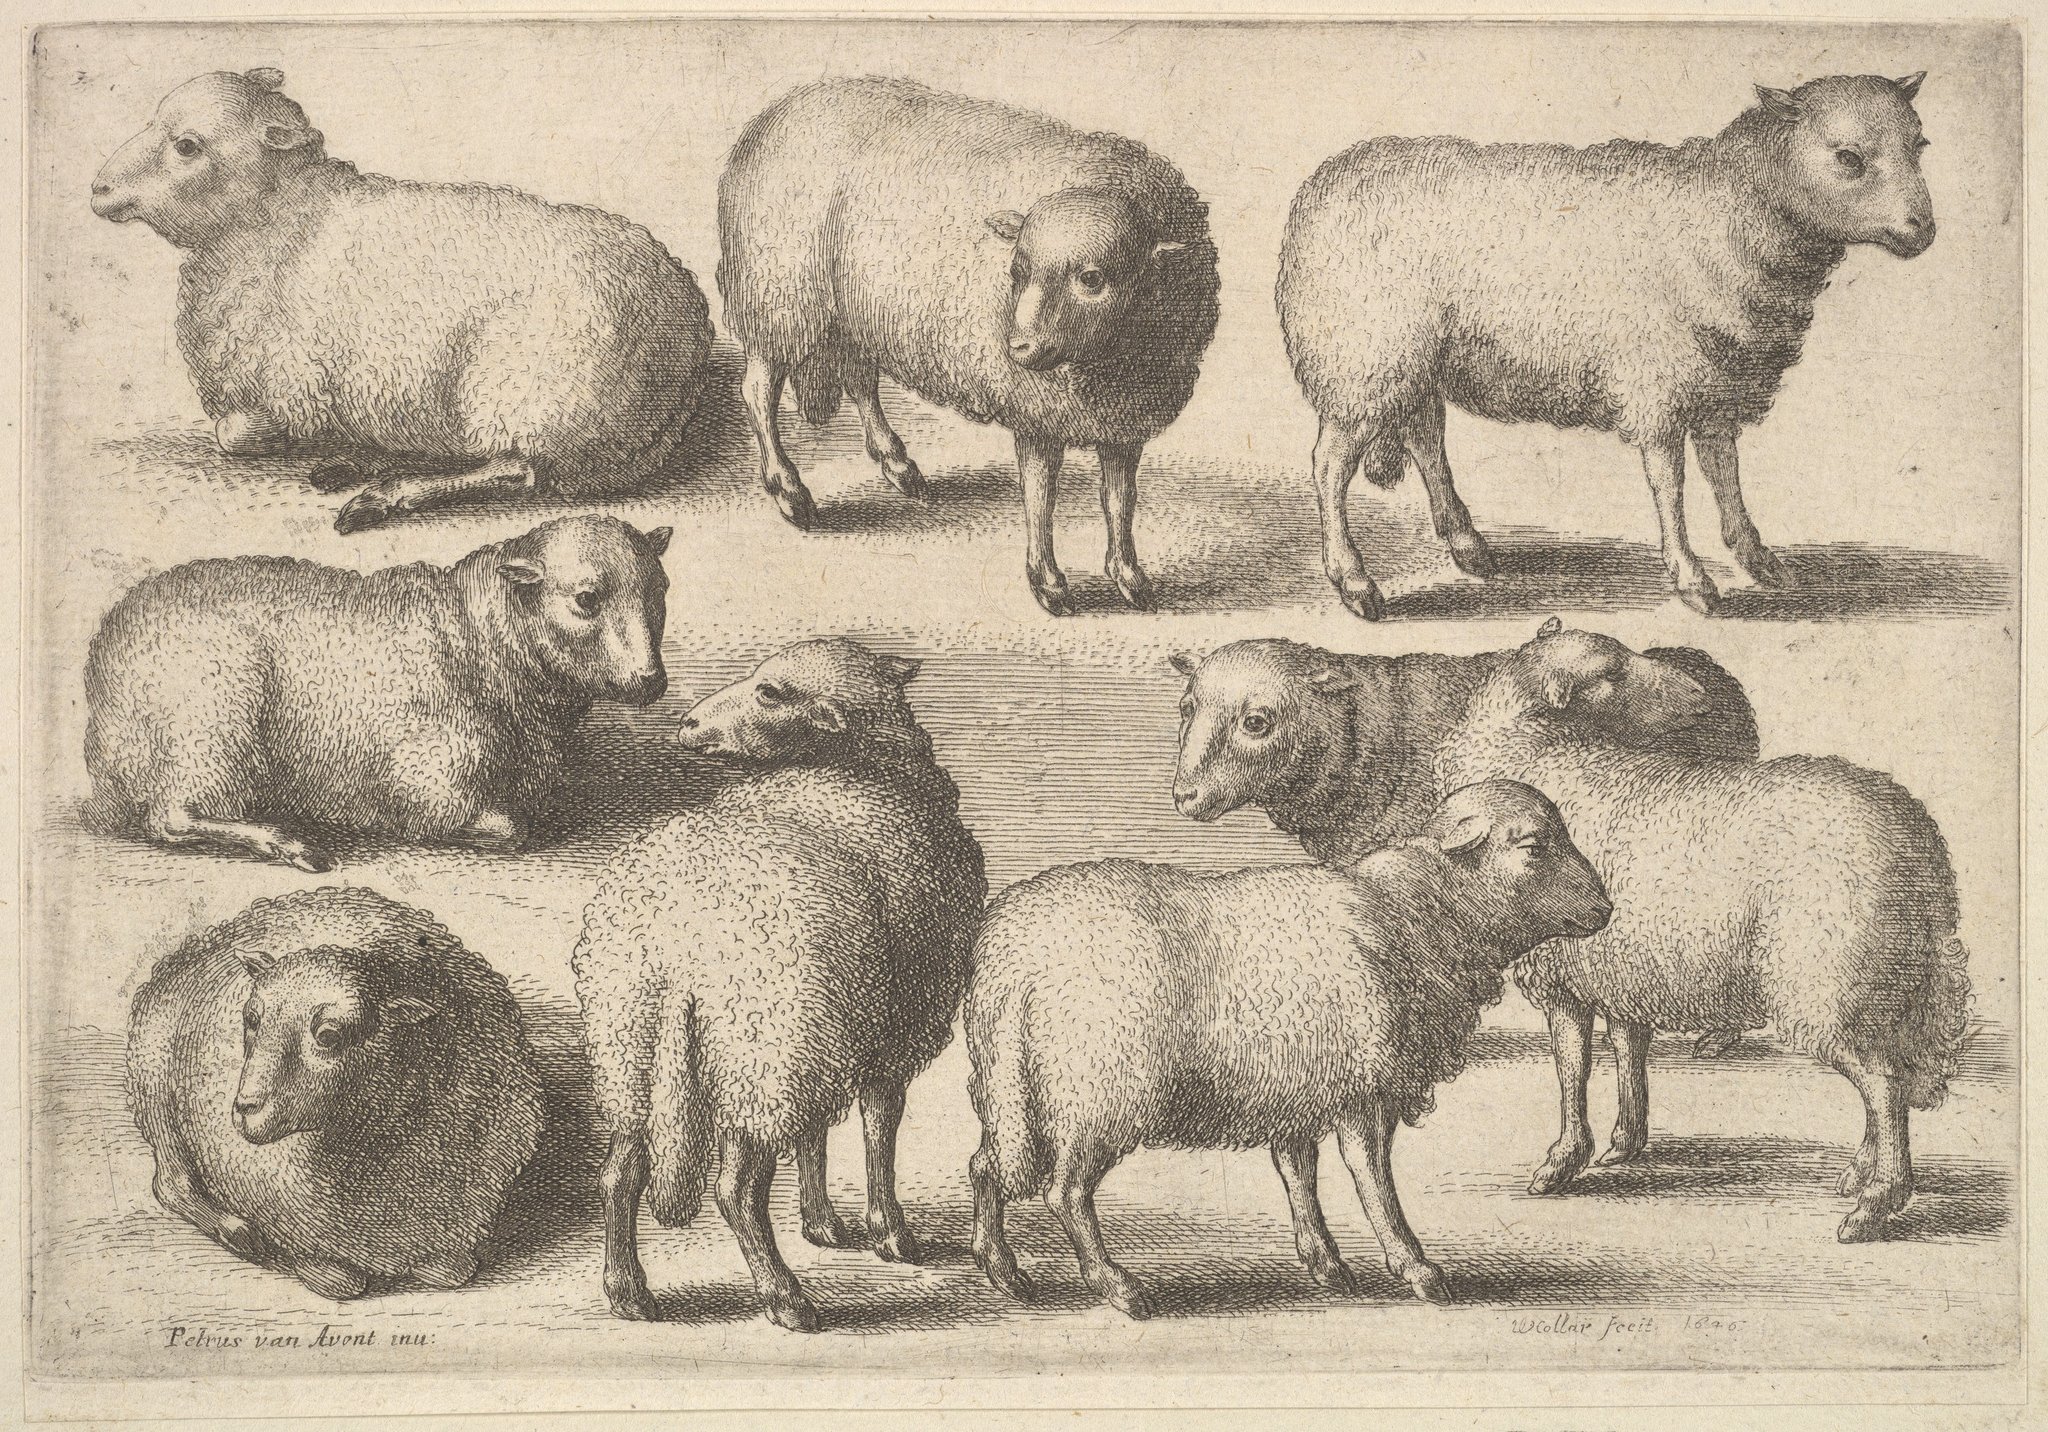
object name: print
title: Nine Sheep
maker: wenceslaus hollar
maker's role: artist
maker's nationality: bohemian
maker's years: 1607-1677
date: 1646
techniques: etching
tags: sheep